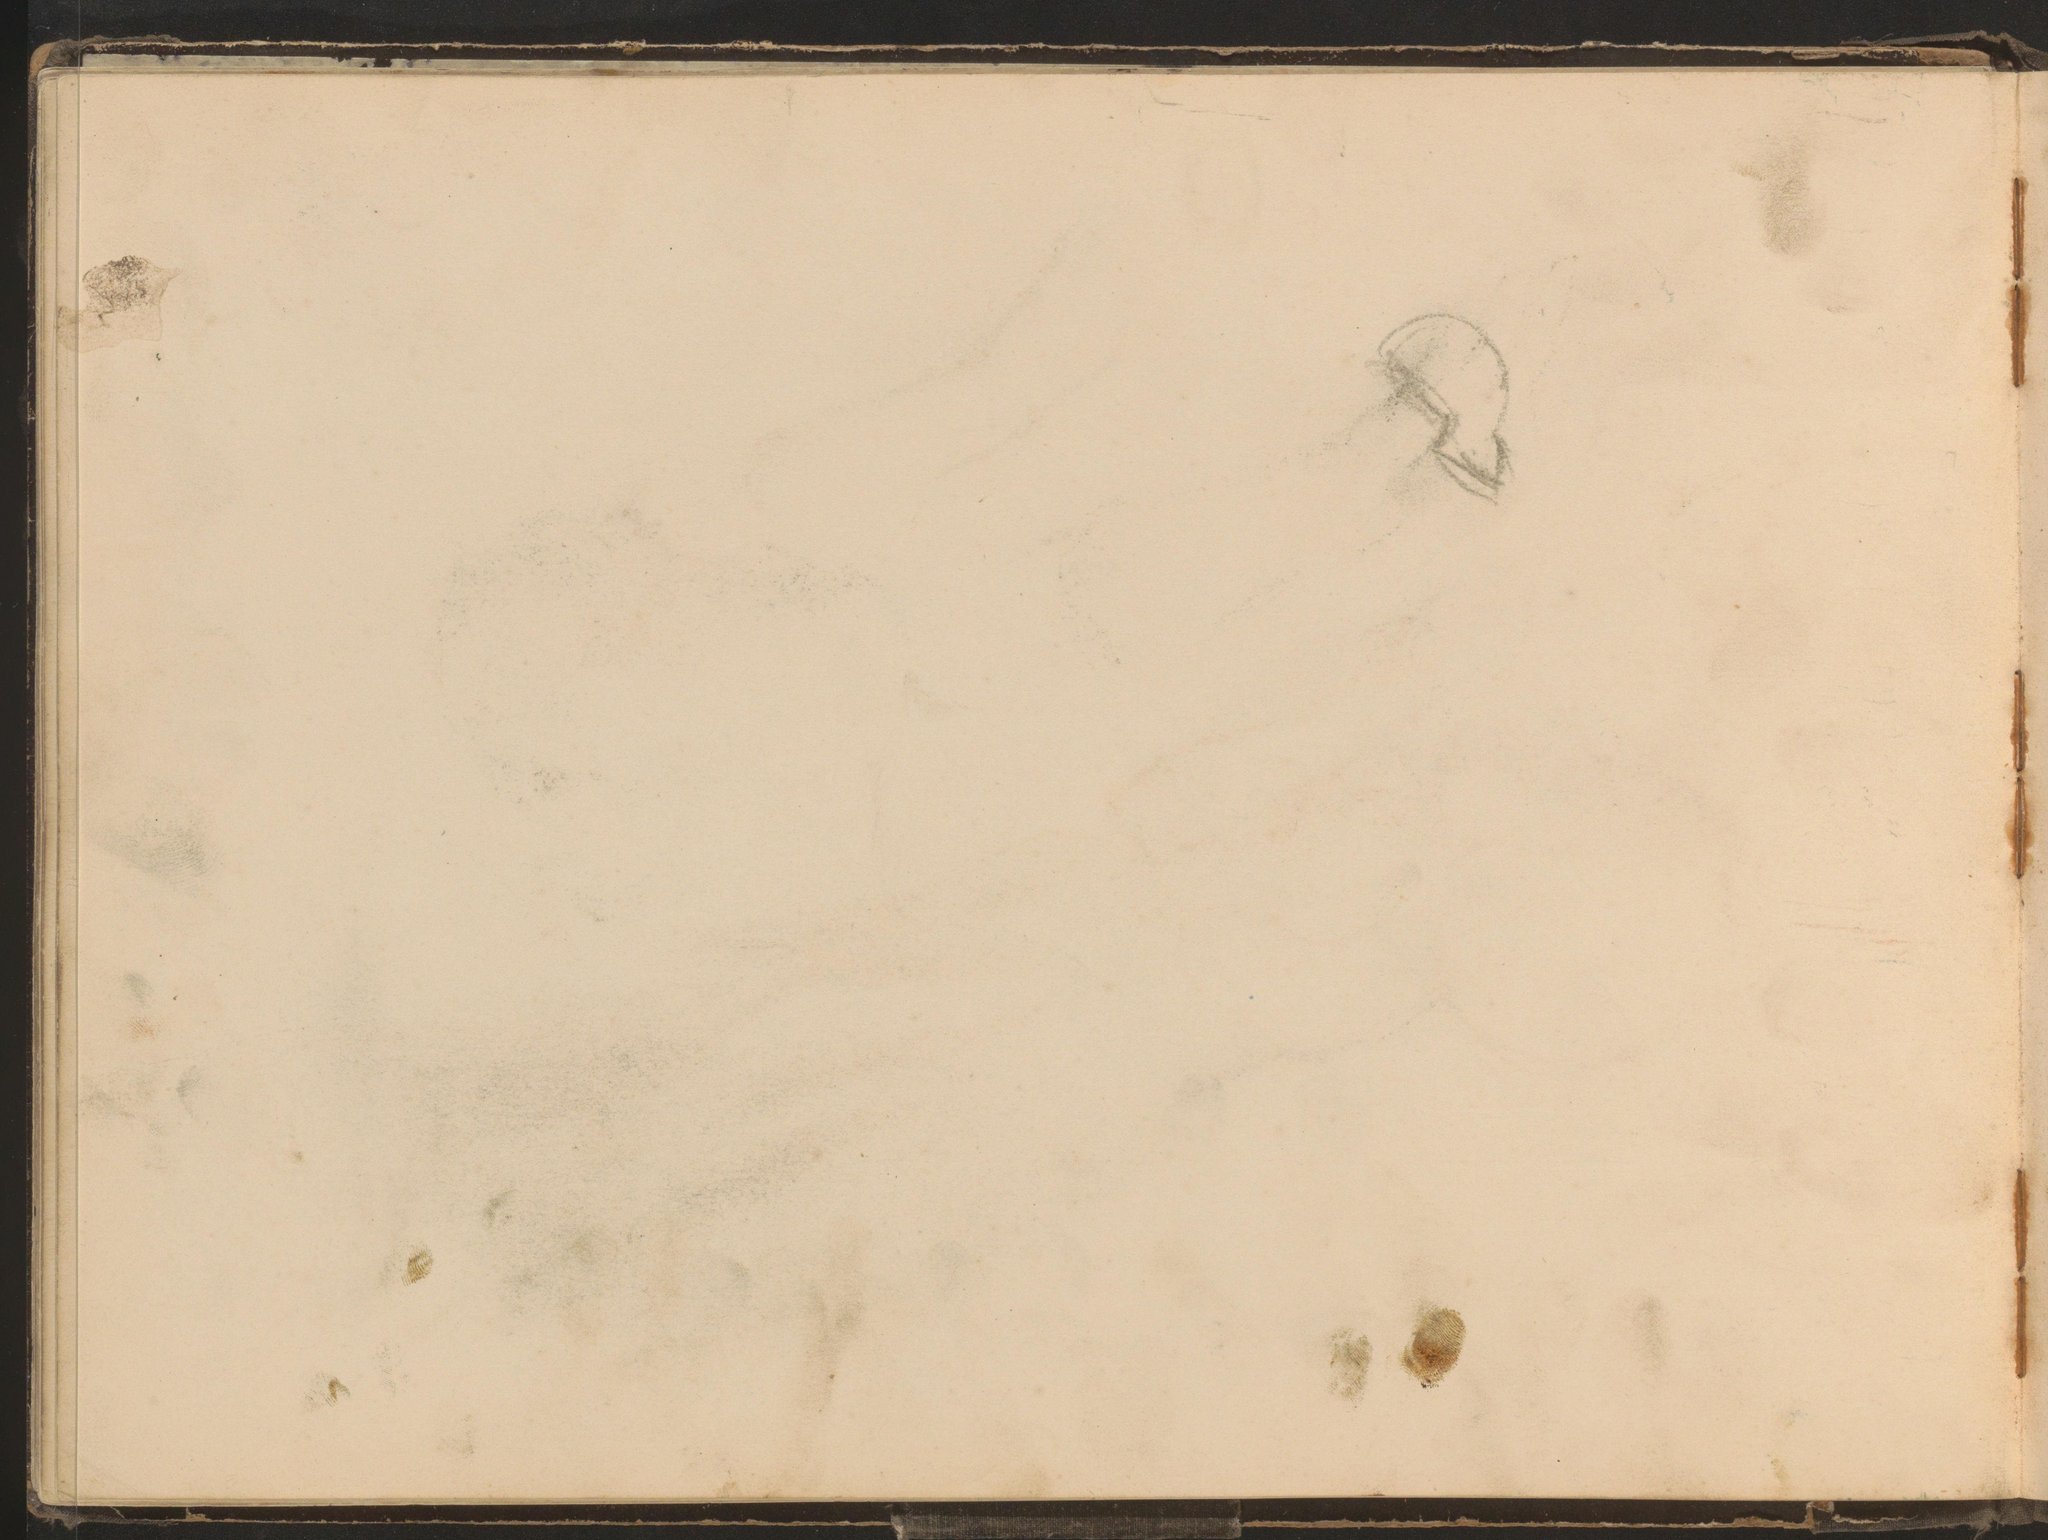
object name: sketchbook leaf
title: Studie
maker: albert neuhuys (1844-1914)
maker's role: draughtsman, painter, print maker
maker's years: 1844-1914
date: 1854-1914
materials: chalk, paper, pencil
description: Blad 16 verso uit een schetsboek met 43 bladen.